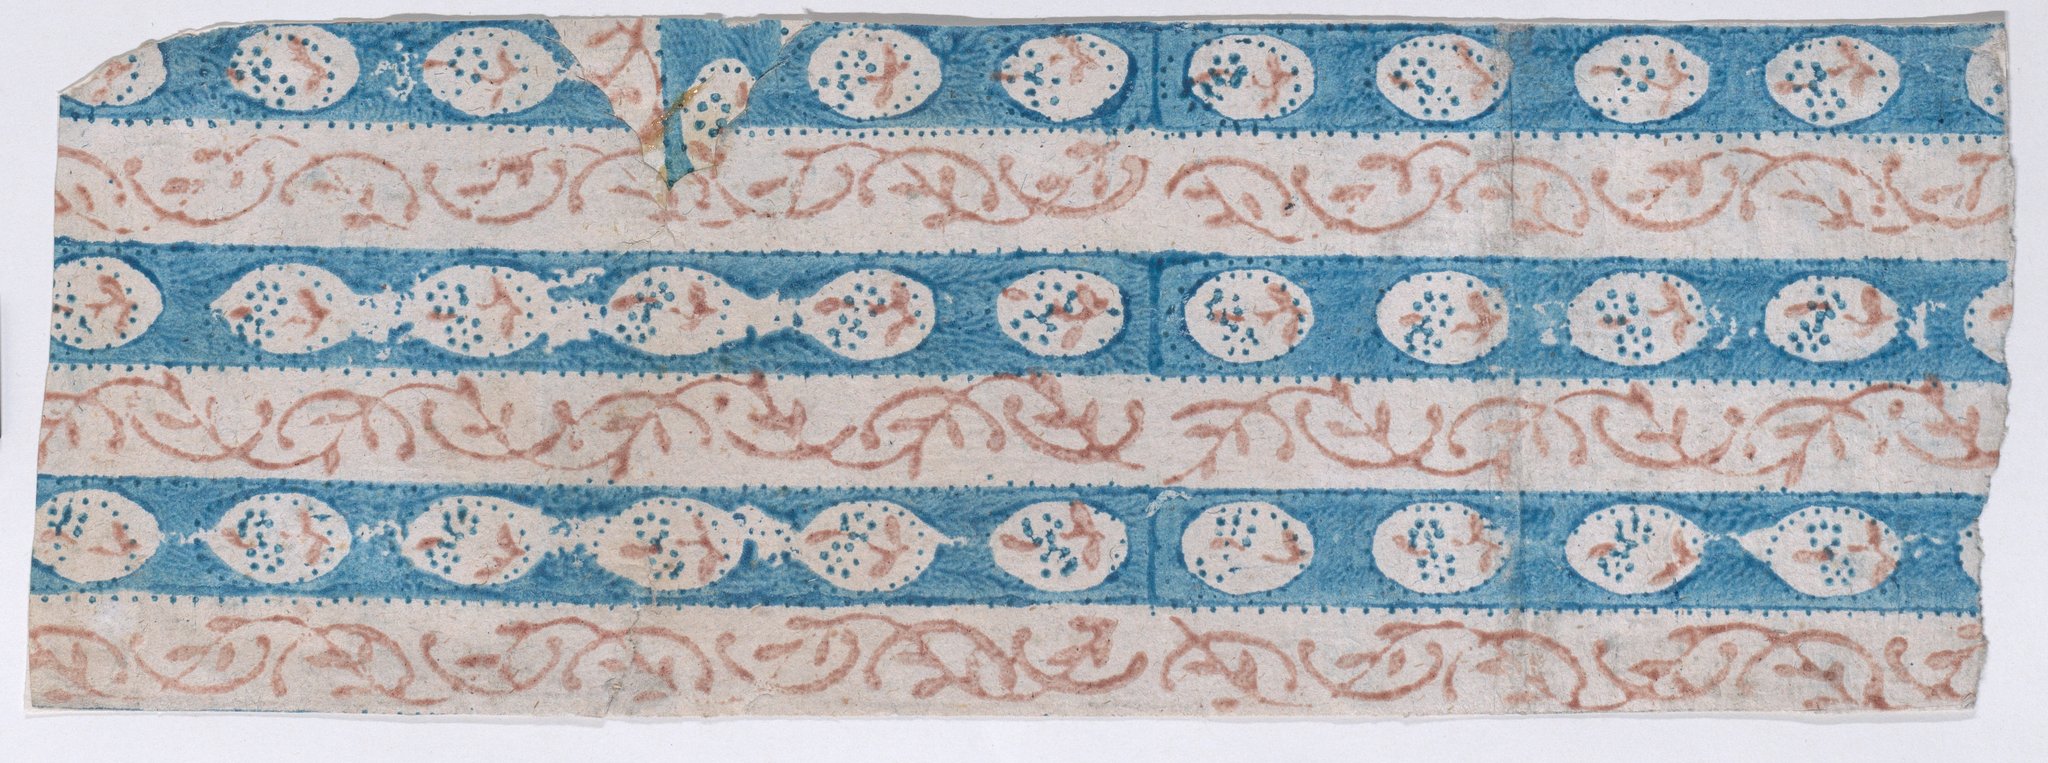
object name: print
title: Sheet with overall vine pattern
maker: Anonymous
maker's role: artist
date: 1801-1900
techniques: relief print